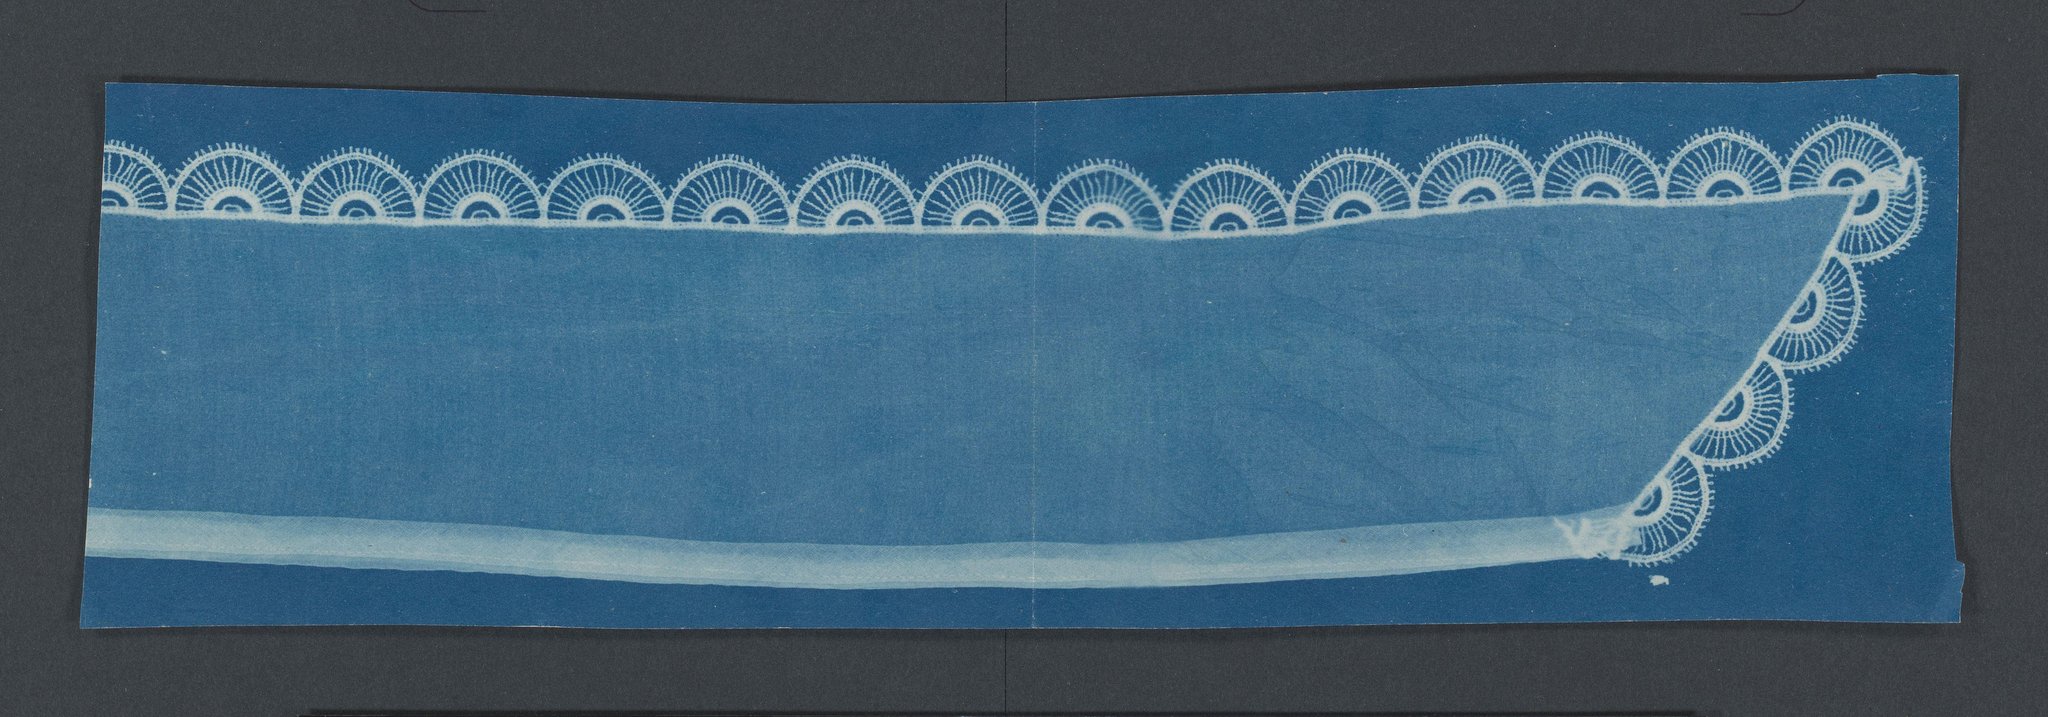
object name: photogram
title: Kant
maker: Anonymous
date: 1900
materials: paper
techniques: cyanotype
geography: france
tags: lace